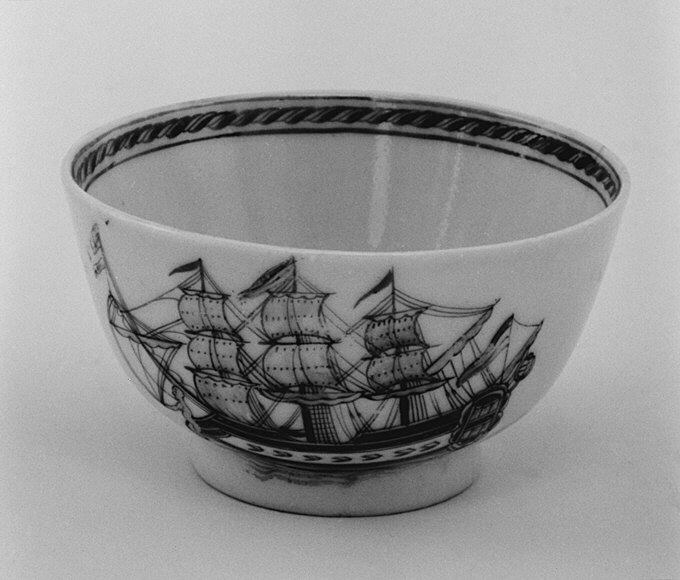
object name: cup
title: Cup (part of a set)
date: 1770-1780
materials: hard paste porcelain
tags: ships